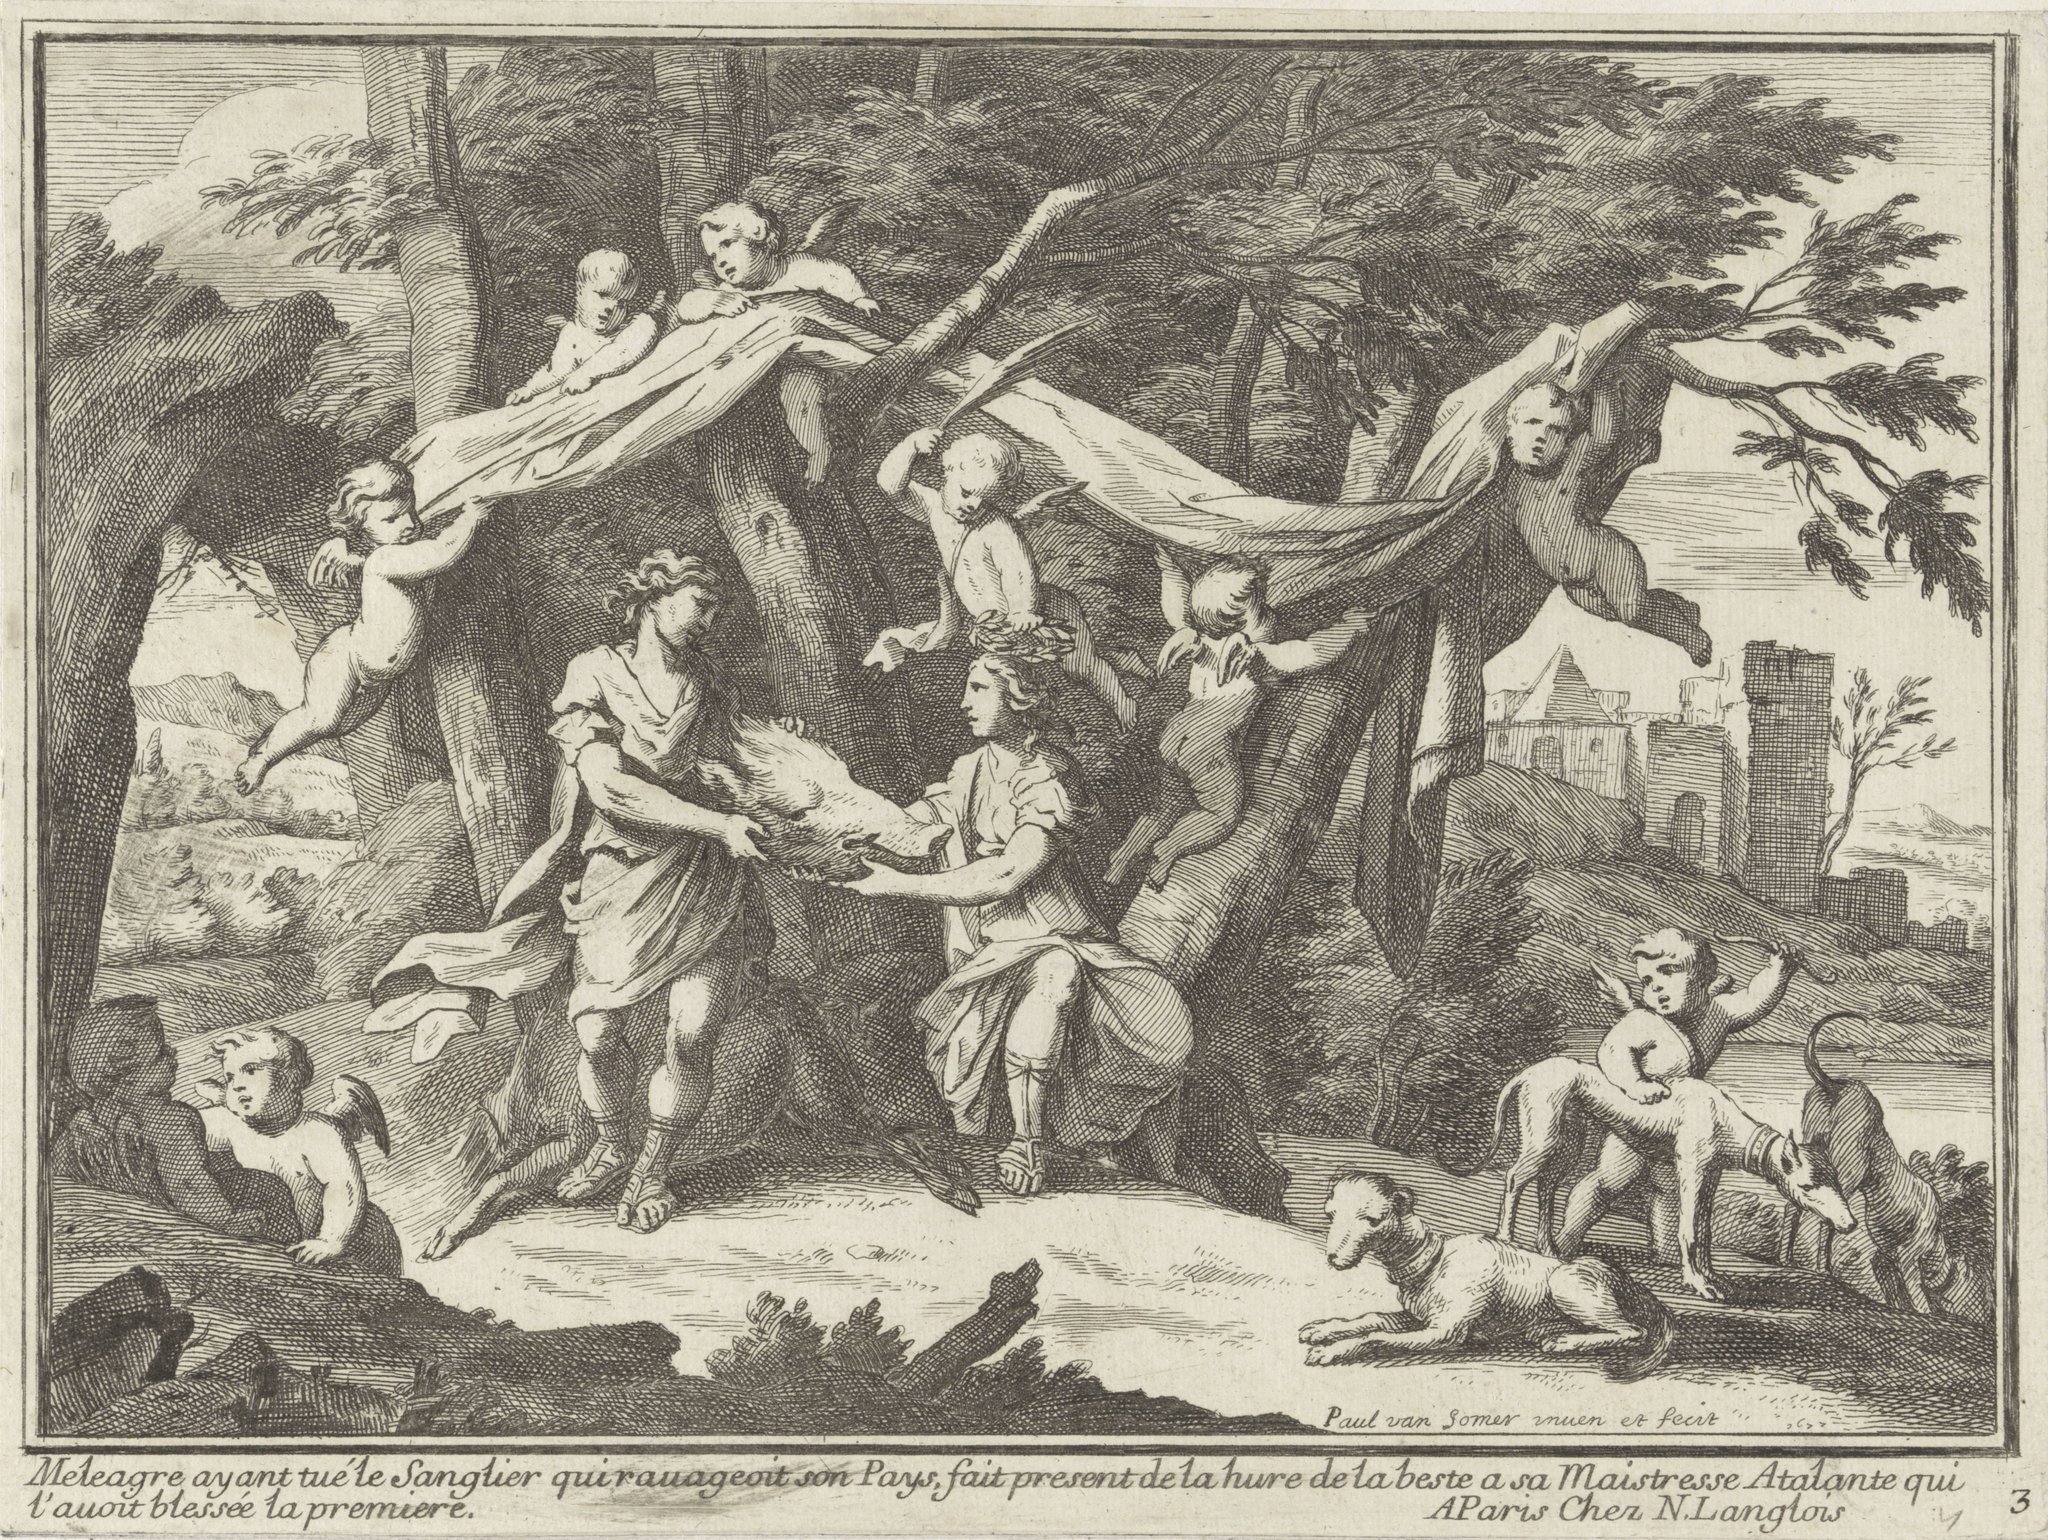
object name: print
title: Meleager en Atalanta na de jacht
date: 1670-1697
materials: paper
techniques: engraving, etching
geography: paris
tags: meleager gives the head of the boar to atalanta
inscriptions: collector's mark: Lugt 2228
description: Meleager biedt de gewonde Atalanta de kop van het everzwijn aan. Op de voorgrond drie jachthonden. Putti houden een draperie op boven het koppel. Onder de afbeelding een verklarende tekst in het Frans. Scène uit Ovidius’ Metamorfosen (Met. VIII, 260-546).